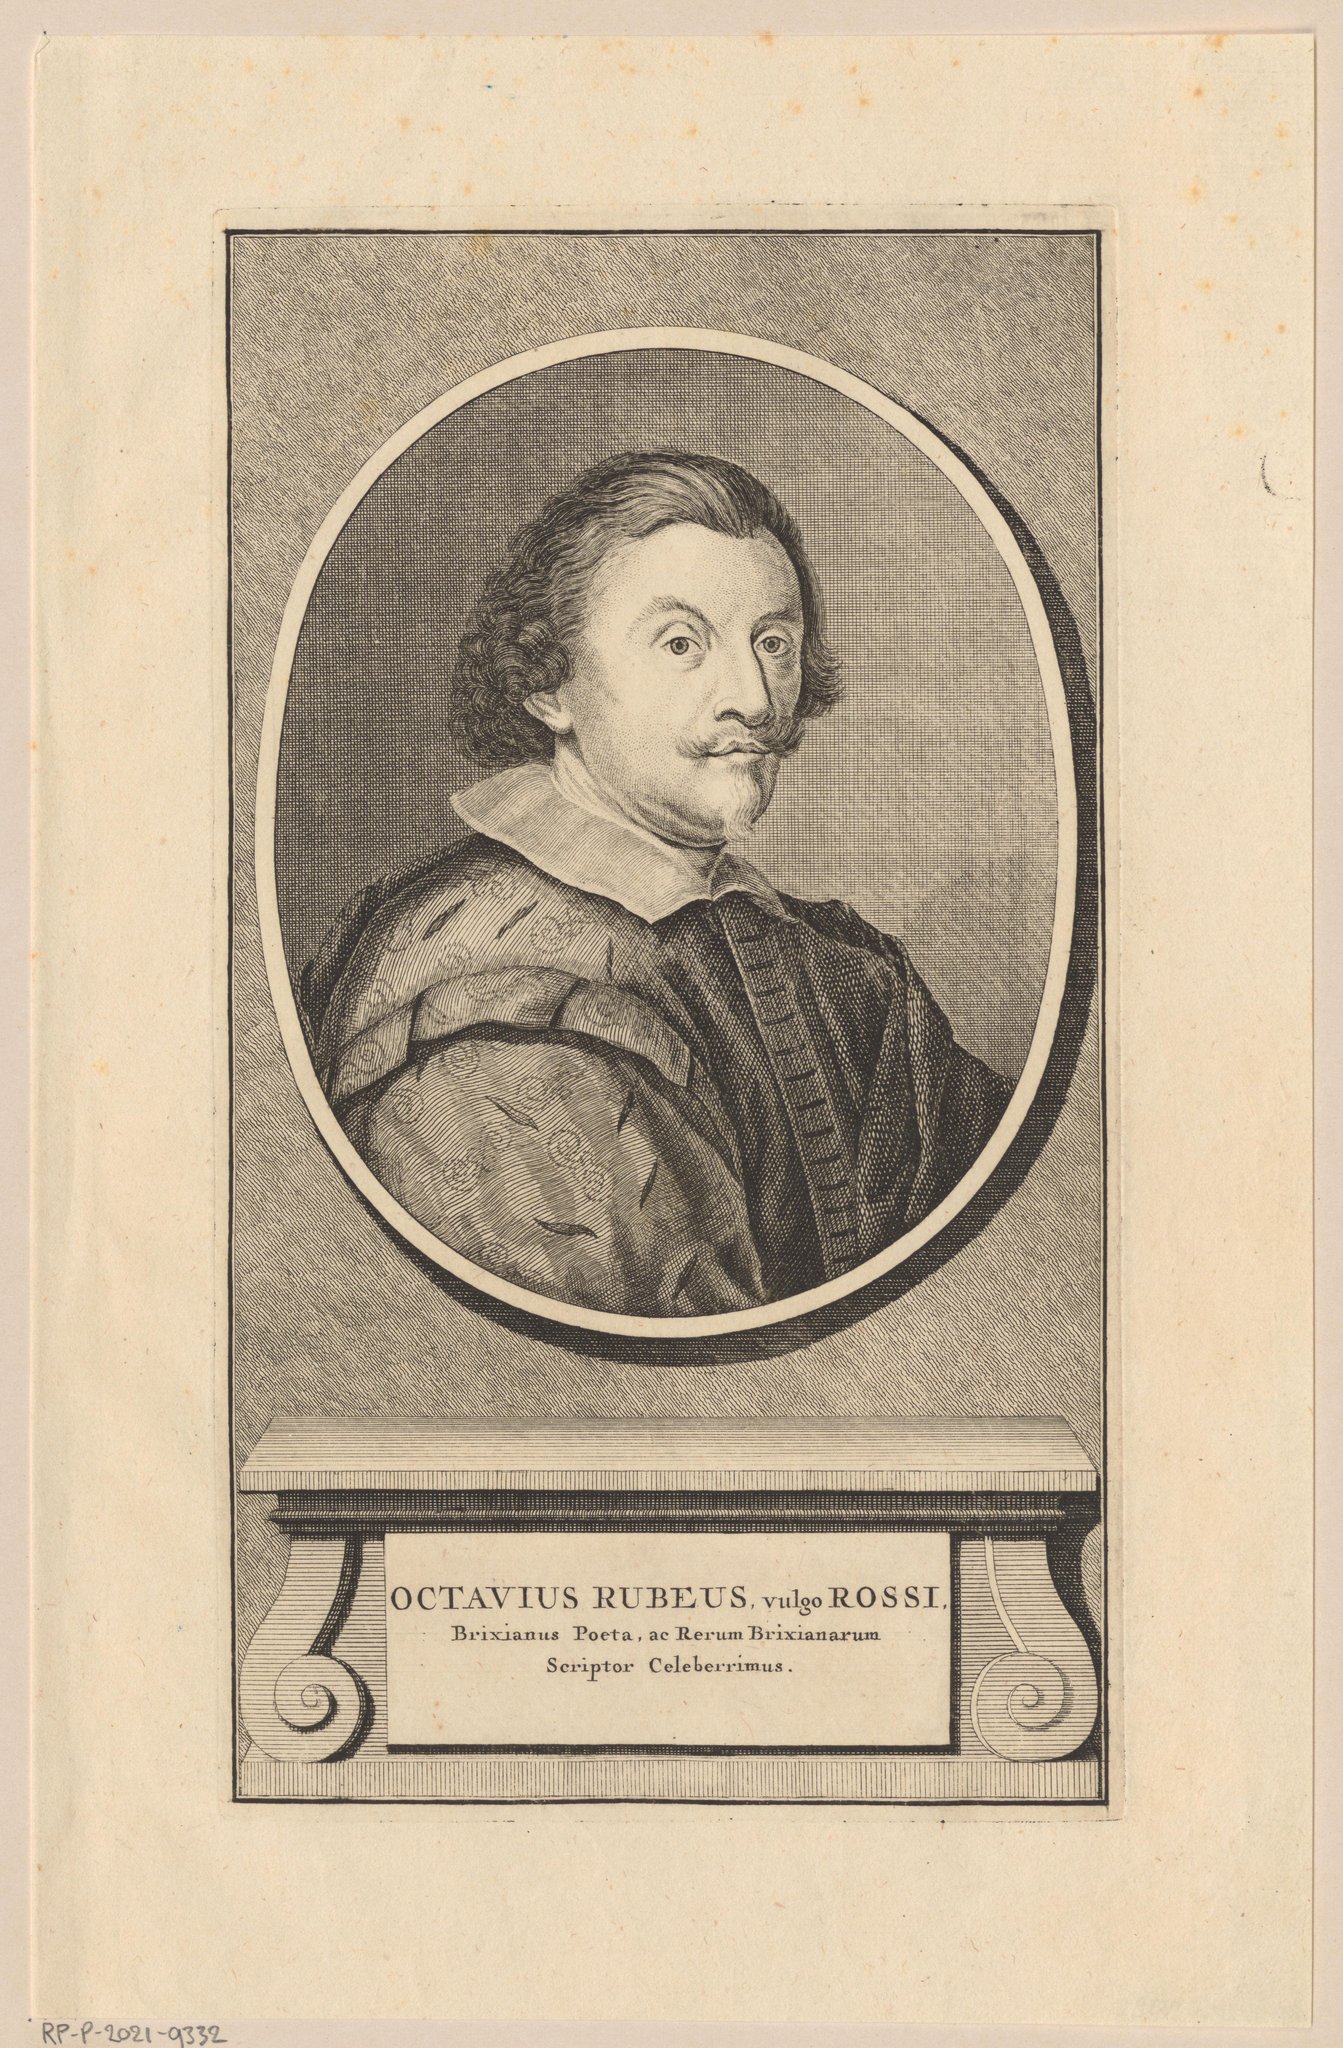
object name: print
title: Portret van Octavio de'Rossi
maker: Anonymous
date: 1722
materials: paper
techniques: engraving, etching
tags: historical persons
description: Prent mogelijk uit: Graevius, Joannes Georgius. Thesaurus antiquitatum et historiarum Italiae (...). Leiden: Pieter van der Aa I, 1722, dl. 4.2.